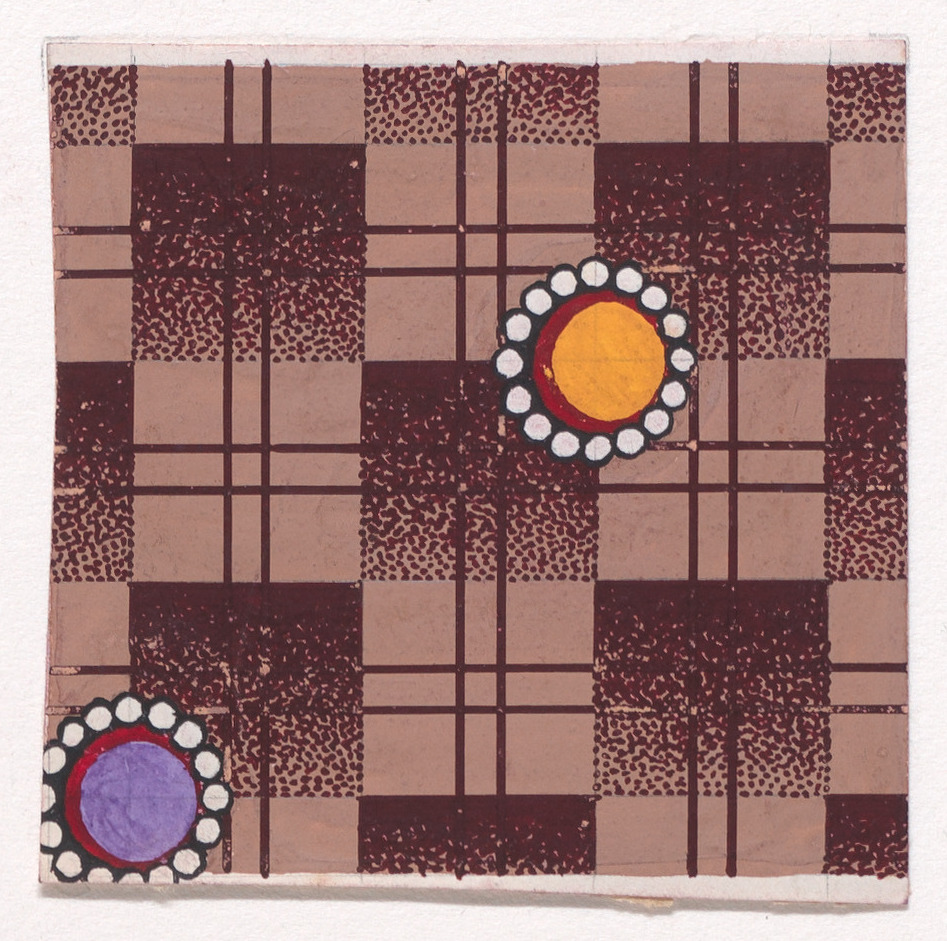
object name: drawing ornament architecture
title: Textile Design with Alternating Rows of Circles Framed by Pearls over a Checked Background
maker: anonymous, alsatian, 19th century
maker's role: artist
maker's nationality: alsatian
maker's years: 1800-1900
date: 1840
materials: gouache